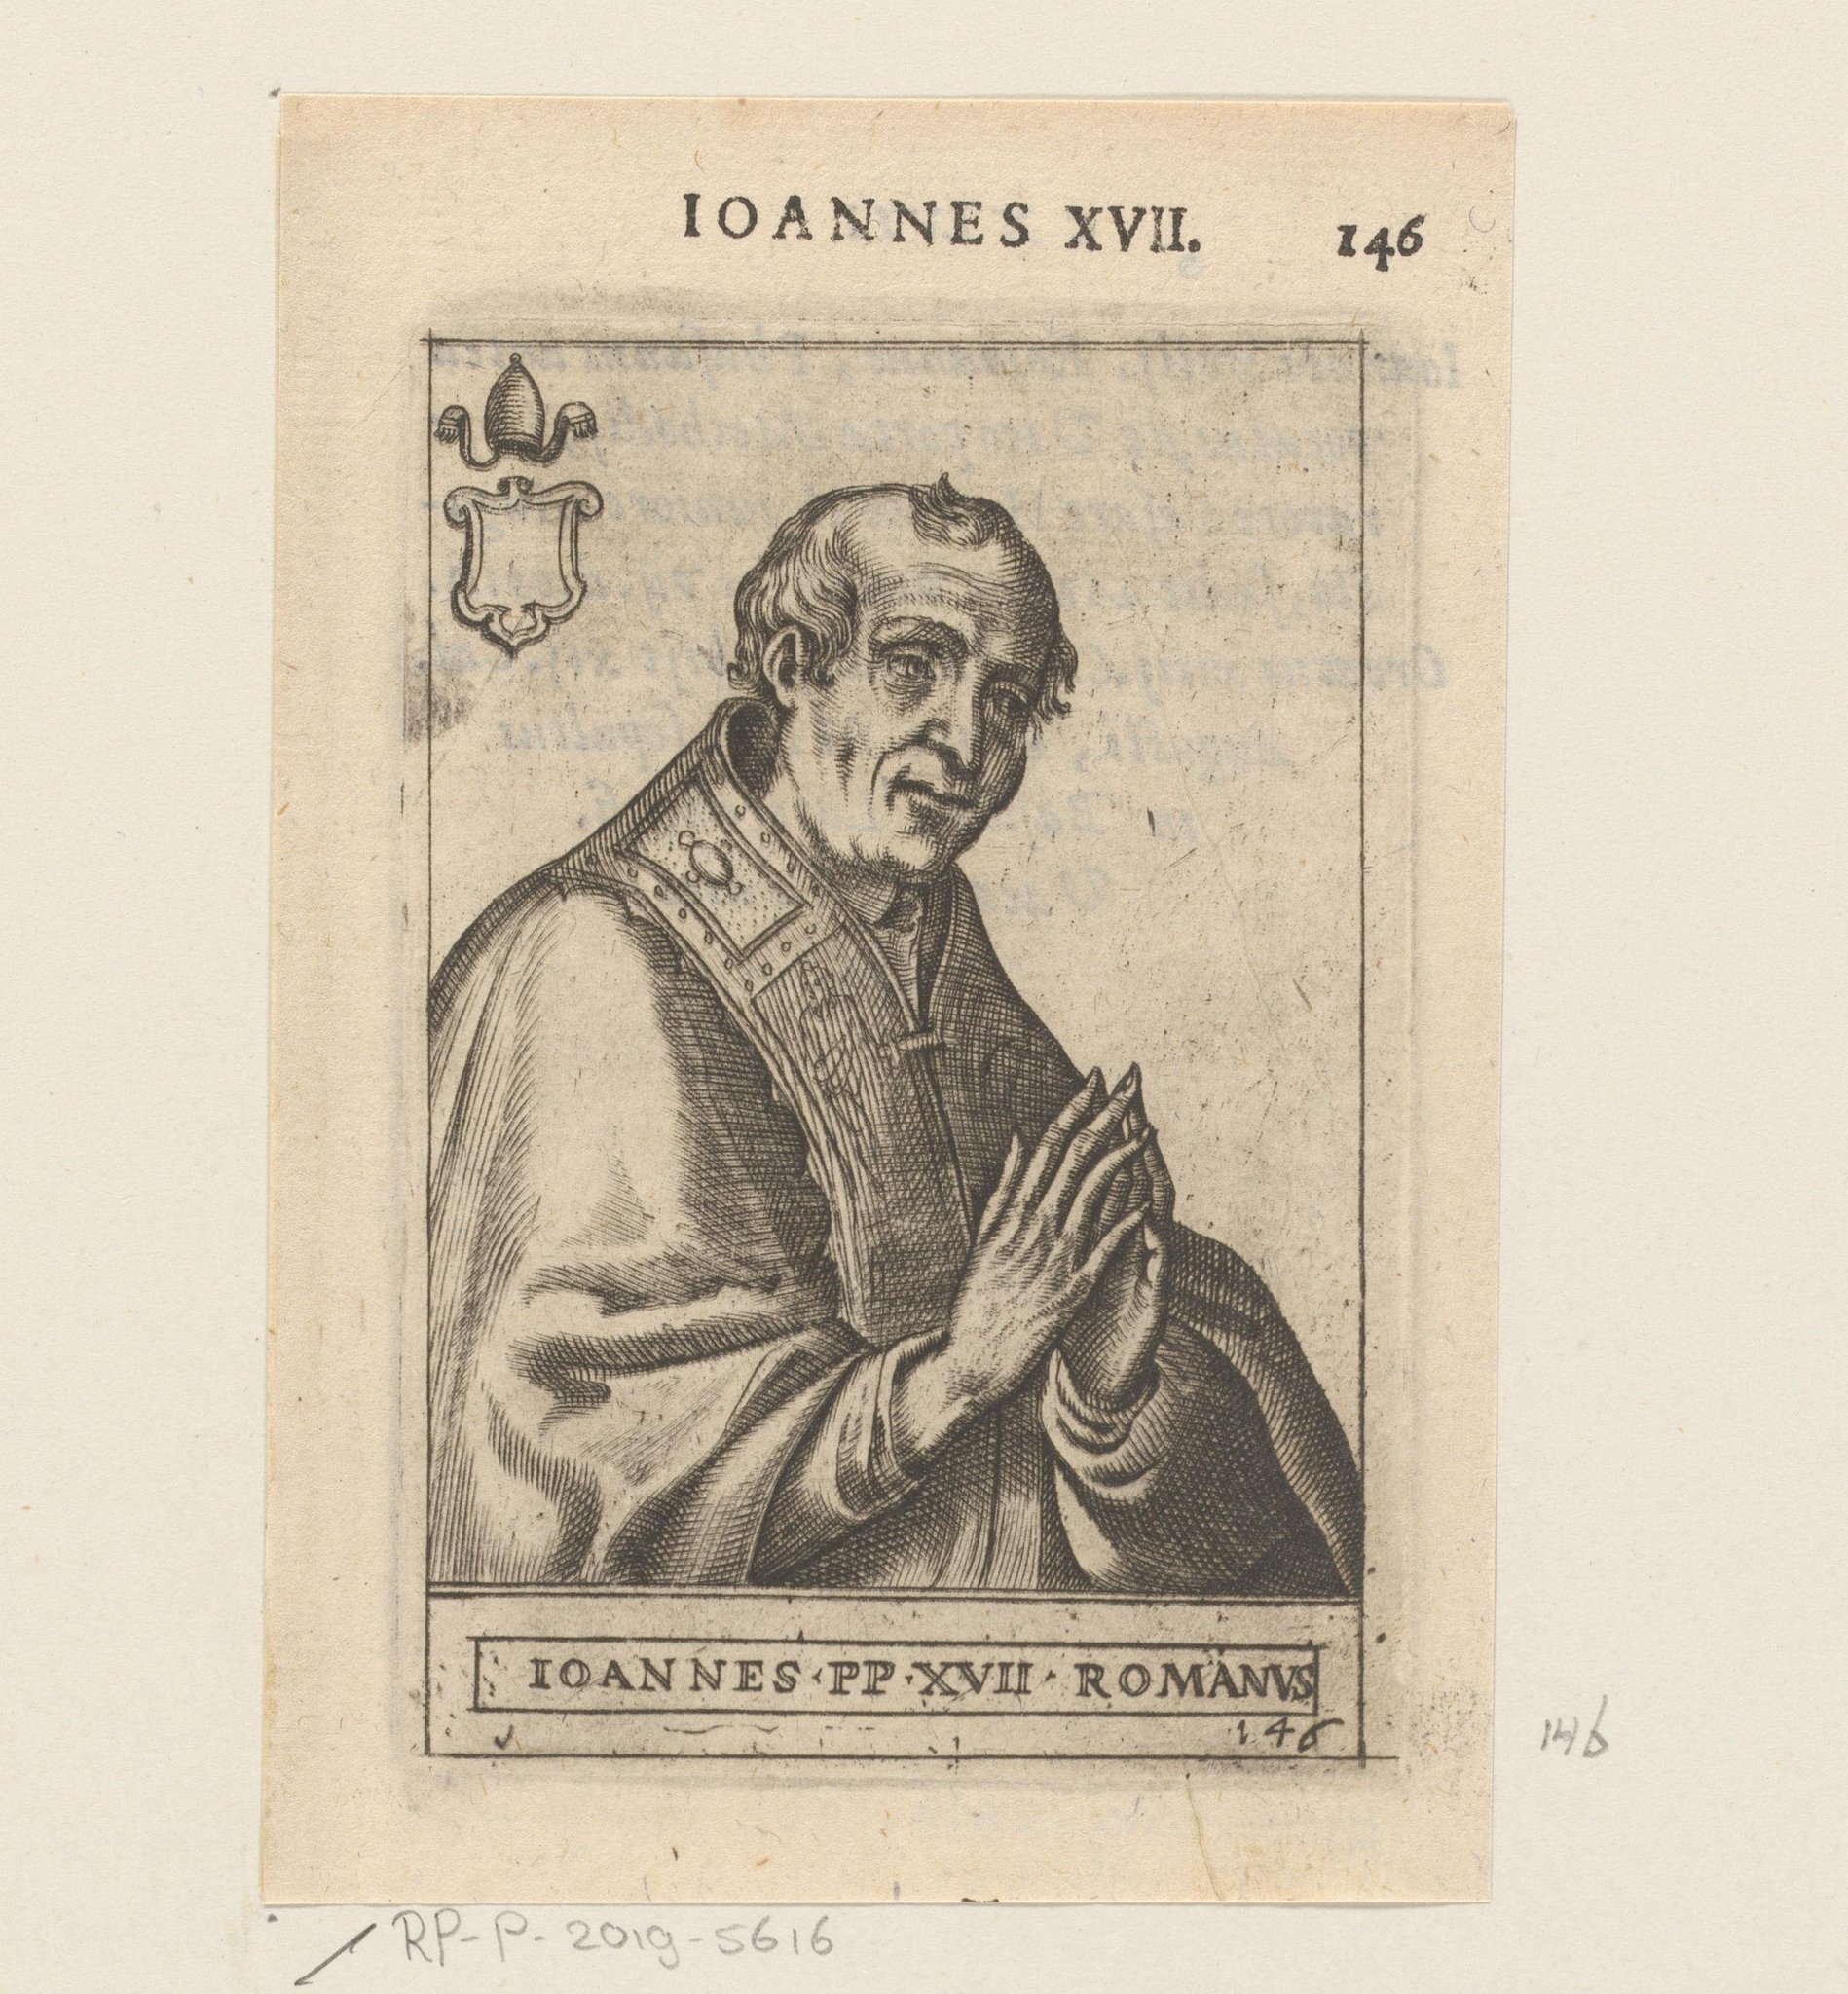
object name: book illustration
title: Portret van paus Johannes XVII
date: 1595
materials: paper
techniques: engraving, letterpress printing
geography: rome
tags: rome, historical persons, pope, armorial bearing, heraldry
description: Prent uit: Cavalieri, Giovanni Battista de'. Effigies pontificum romanorum cum eorum vitis (...). Rome: Bartolomeo Bonfadino, 1595. Prent voor het eerst verschenen in: Cavalieri, Giovanni Battista de'. Pontificum romanorum effigies (...). Rome: Domenico Basa en Francesco Zanetti, 1580. Prent ook gebruikt in latere publicaties.